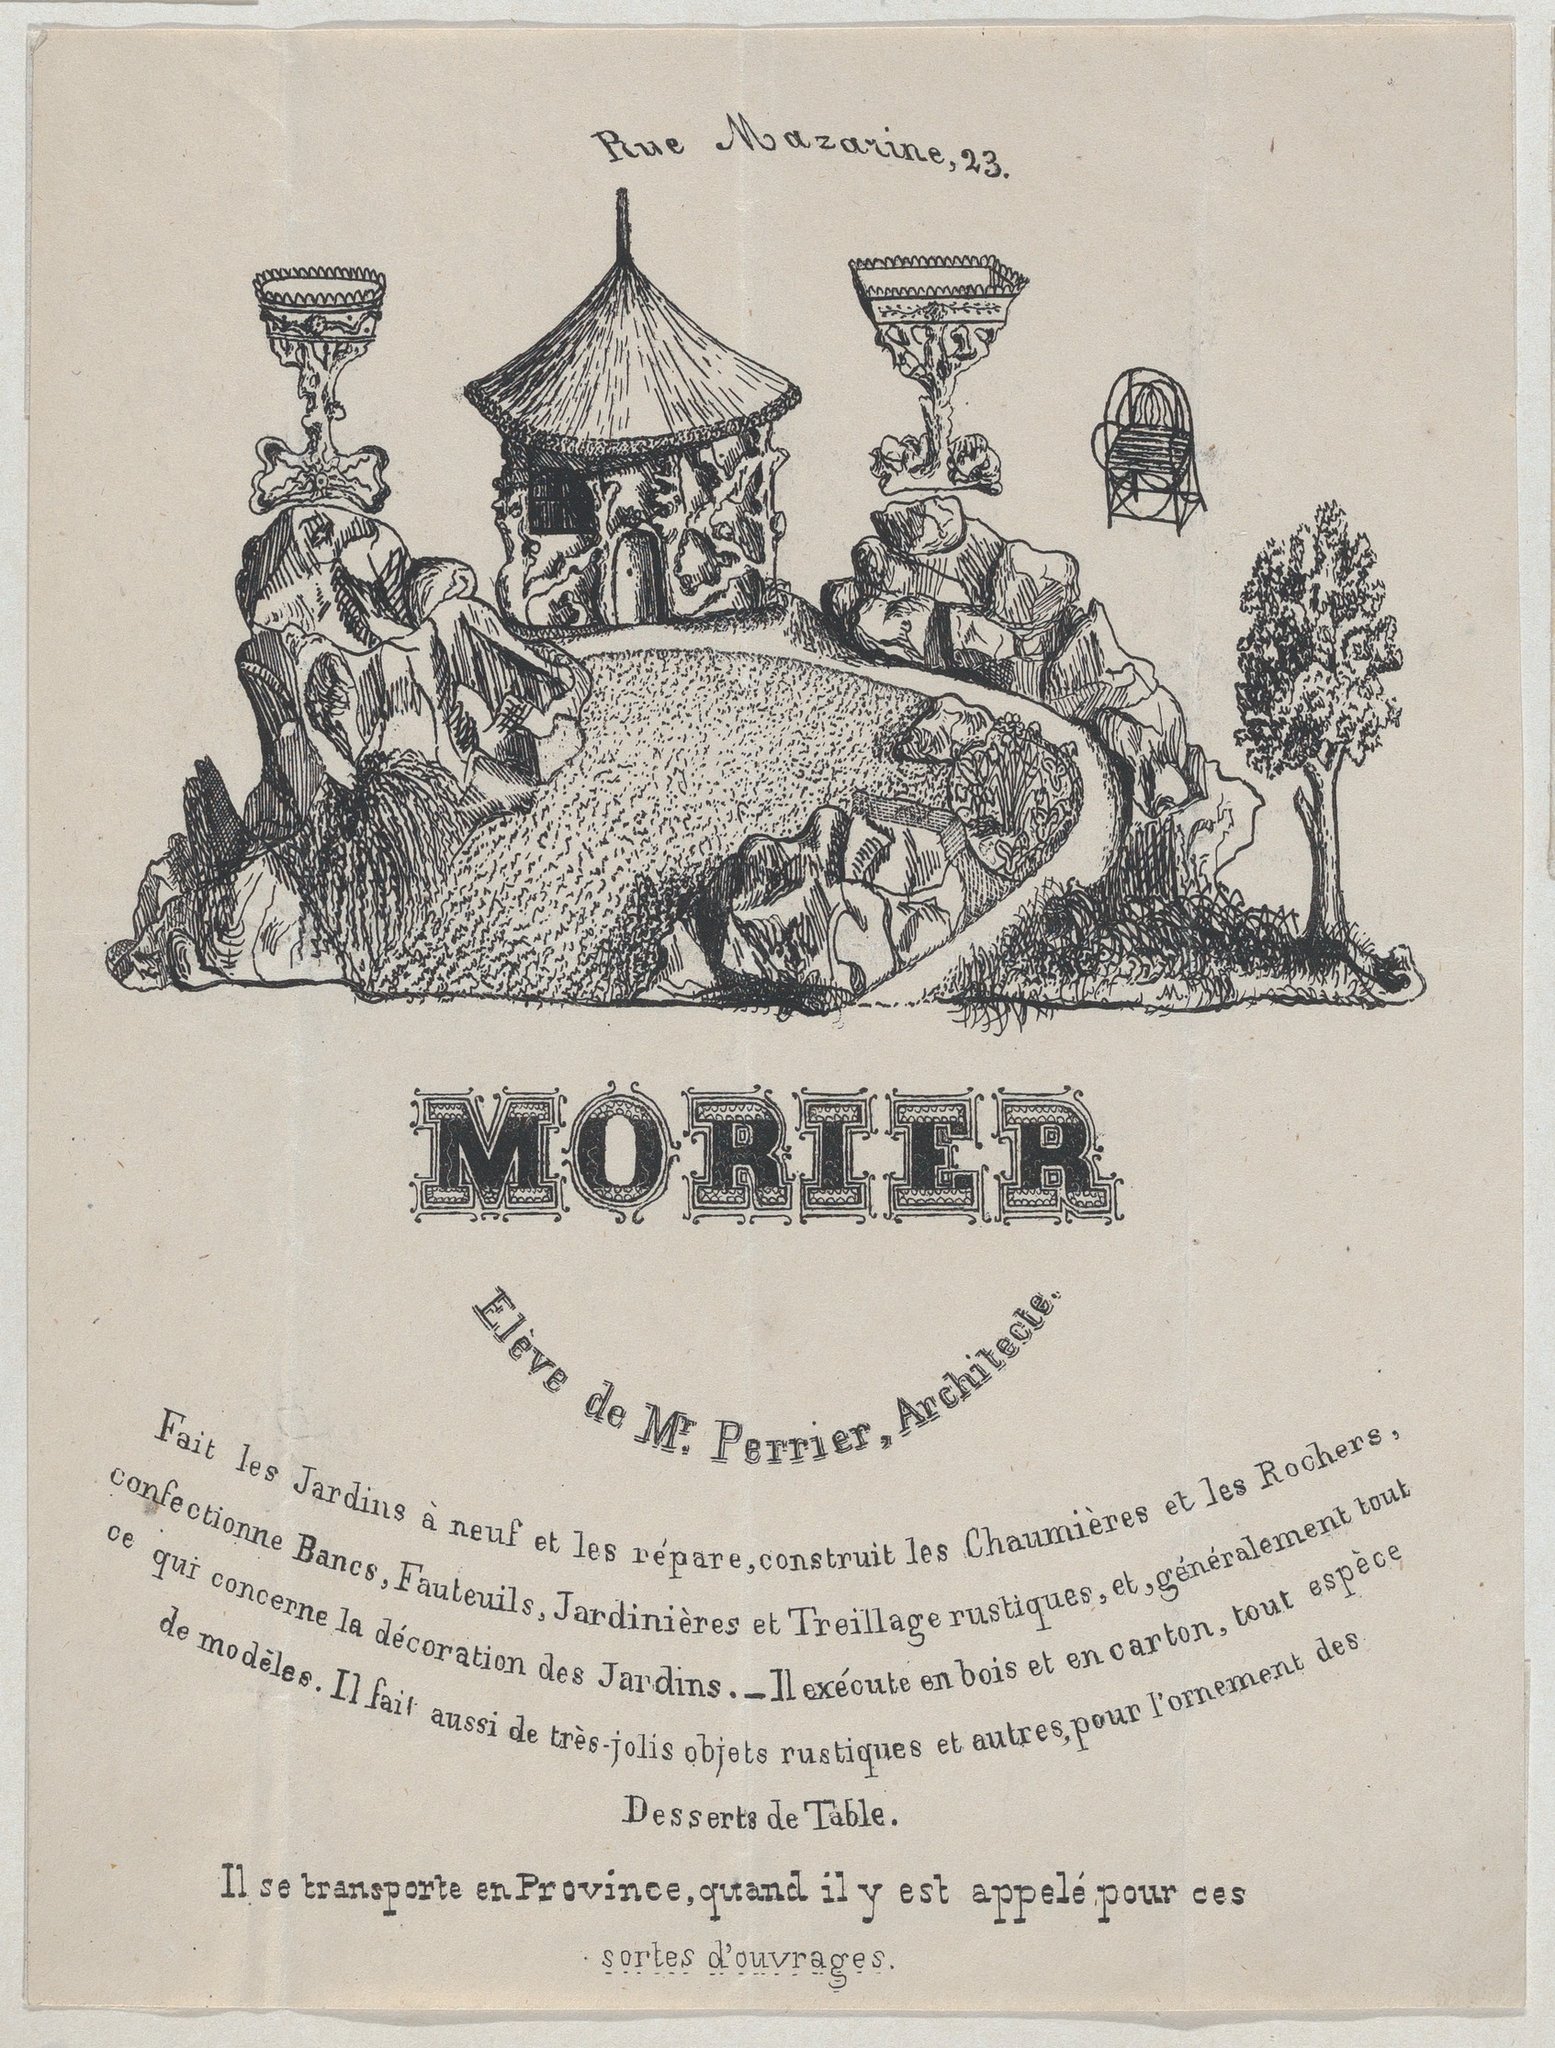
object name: print, ephemera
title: Trade card for Morier, landscape architect, Paris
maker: morier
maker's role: retailer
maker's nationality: french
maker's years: 1800-1900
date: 1801-1900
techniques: lithograph